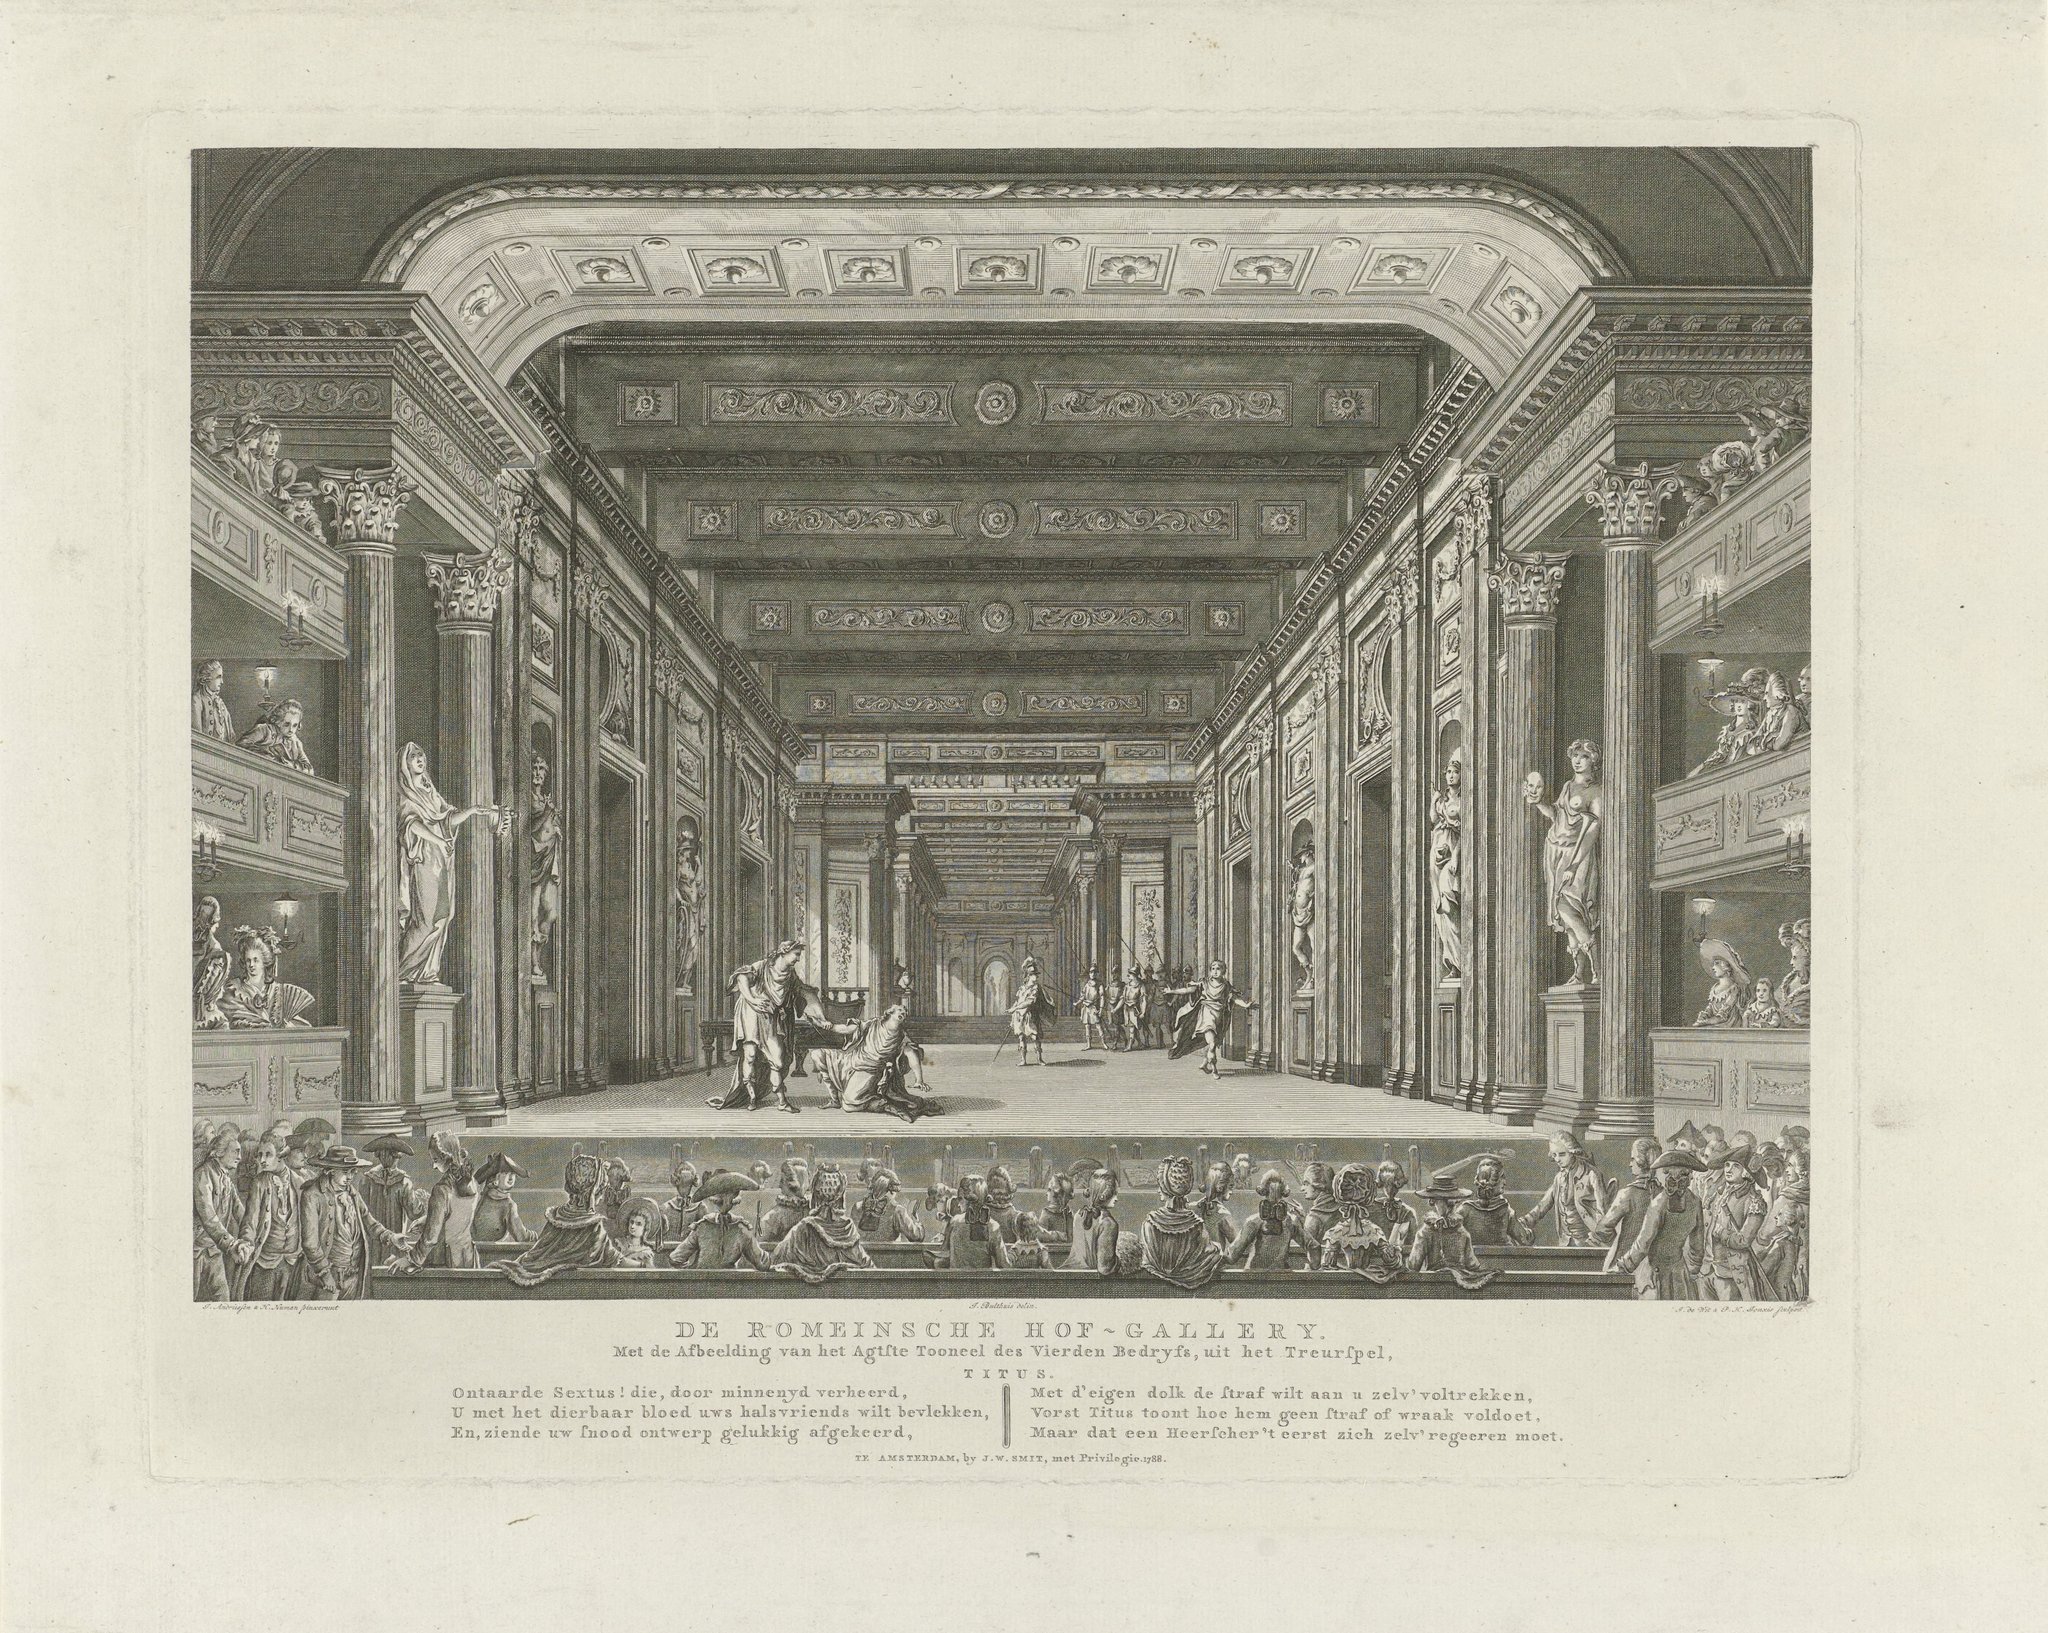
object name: print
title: Schouwburg met toneeldecor: De Romeinsche Hof-Gallery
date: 1788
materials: paper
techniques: engraving, etching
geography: amsterdam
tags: theatre, theatrical performance, stage design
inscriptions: collector's mark: Lugt 2228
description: Toneelvoorstelling in de nieuwe Amsterdamse Schouwburg met het coulissendecor De Romeinsche Hof-Gallery, met scène uit Titus. Het decor gedrukt van een aparte plaat binnen een vernieuwde passe-partout met de zaal, zijloges, pilaren met standbeelden en de façade van het toneel. In het onderschrift een zesregelig vers. Onderdeel van de serie van veertien toneeldecors van de nieuwe Amsterdamse Schouwburg, 1787-1794.